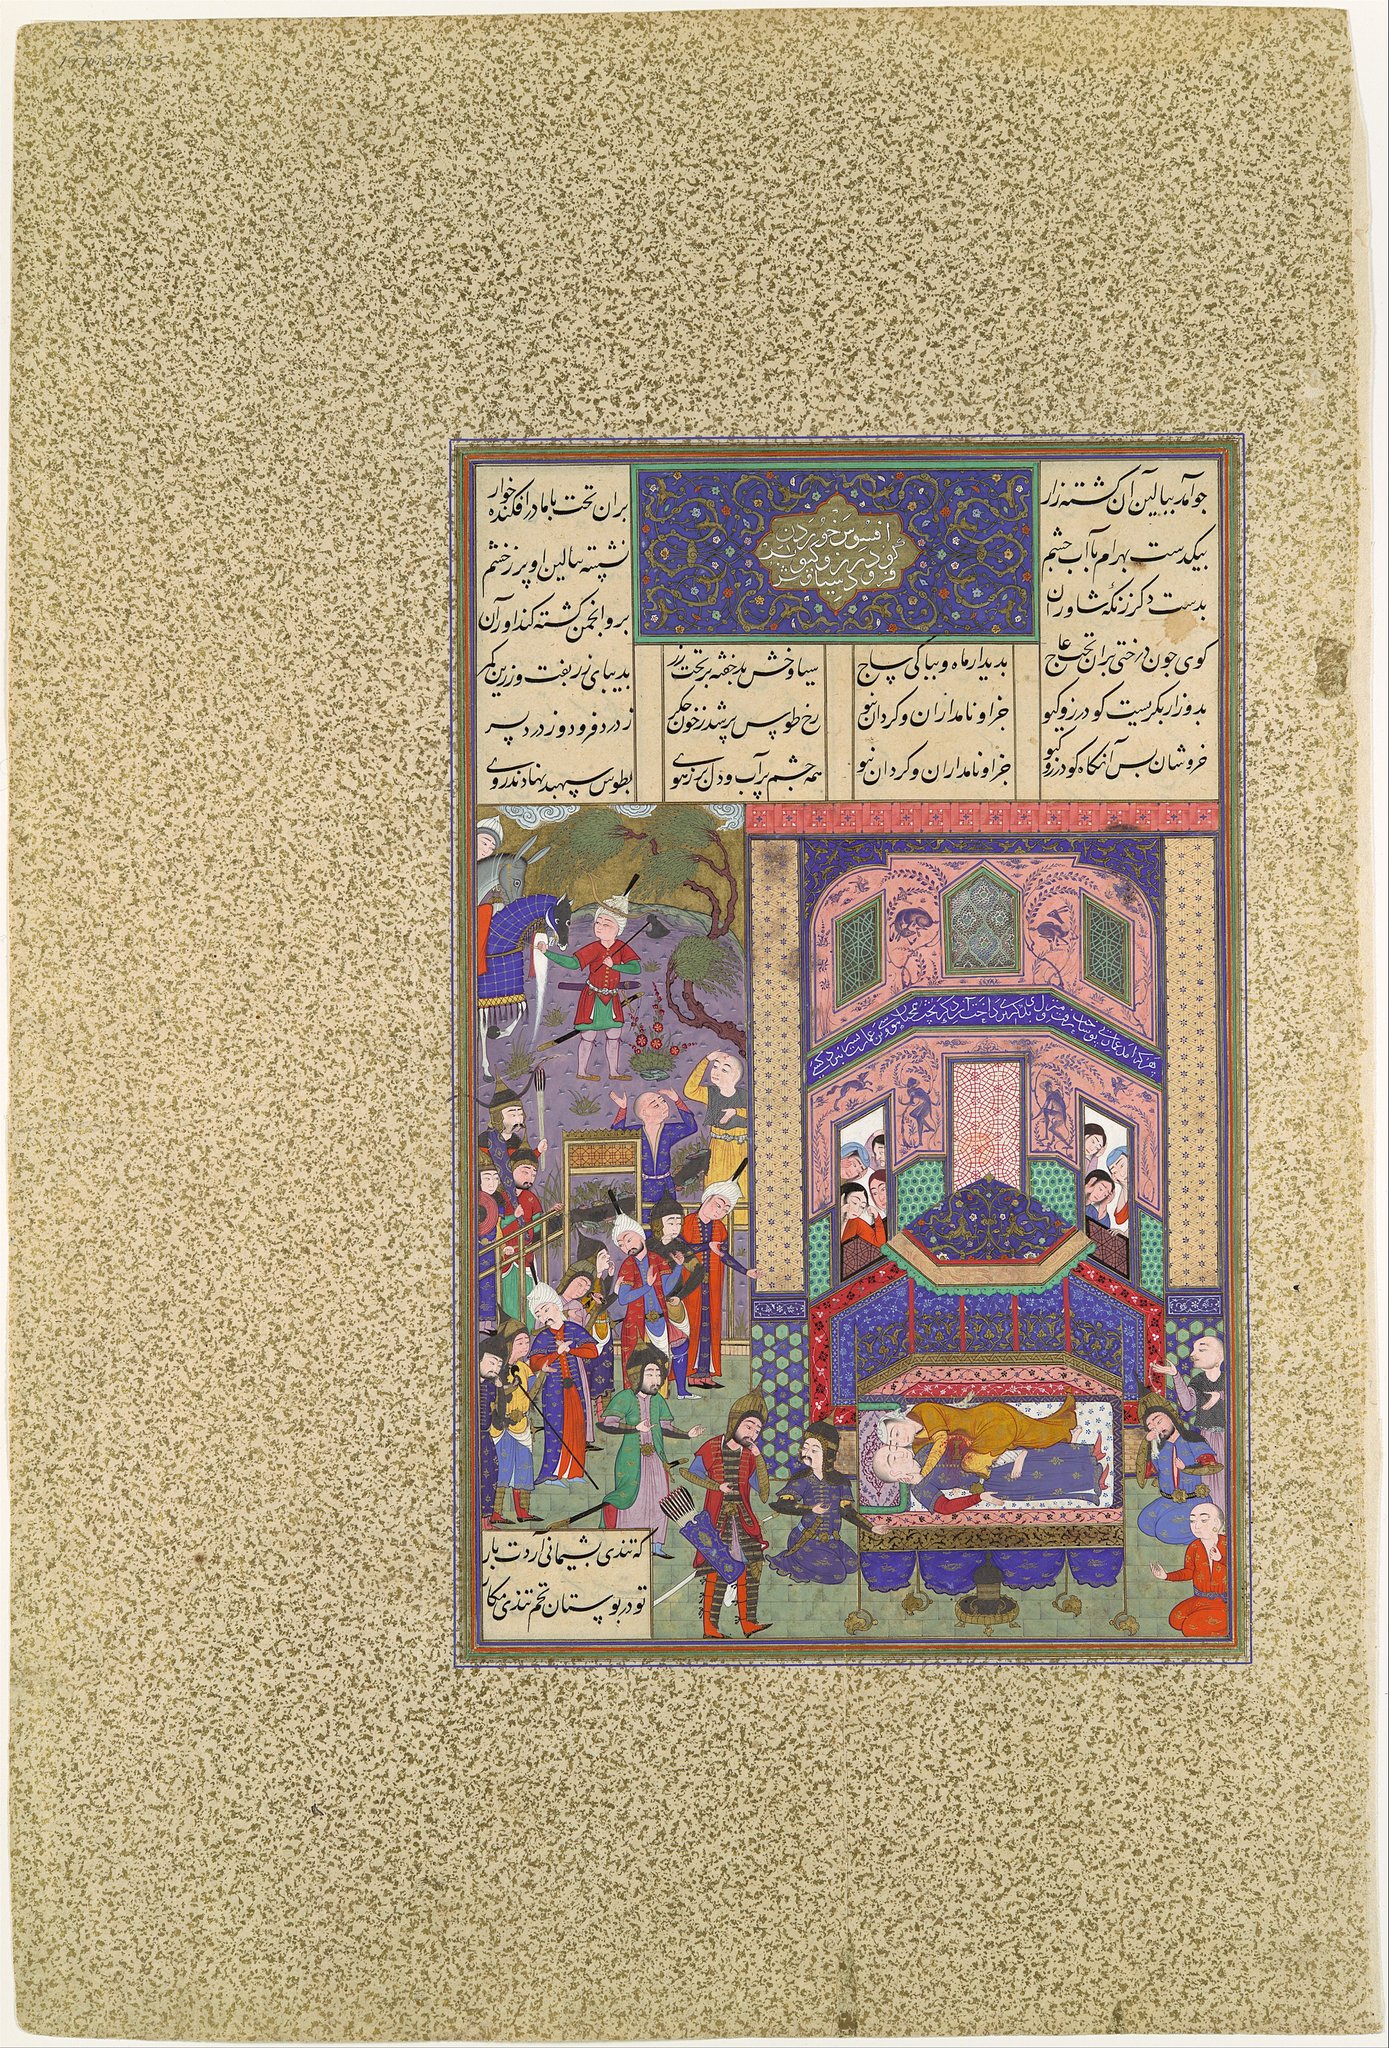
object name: folio from an illustrated manuscript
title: "The Iranians Mourn Farud and Jarira", Folio 236r from the Shahnama (Book of Kings) of Shah Tahmasp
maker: abu'l qasim firdausi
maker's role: author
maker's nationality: iranian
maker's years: 935-1020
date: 1525-1530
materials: gold, ink, paper, silver, watercolor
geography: iran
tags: sadness,men,women,horses,death